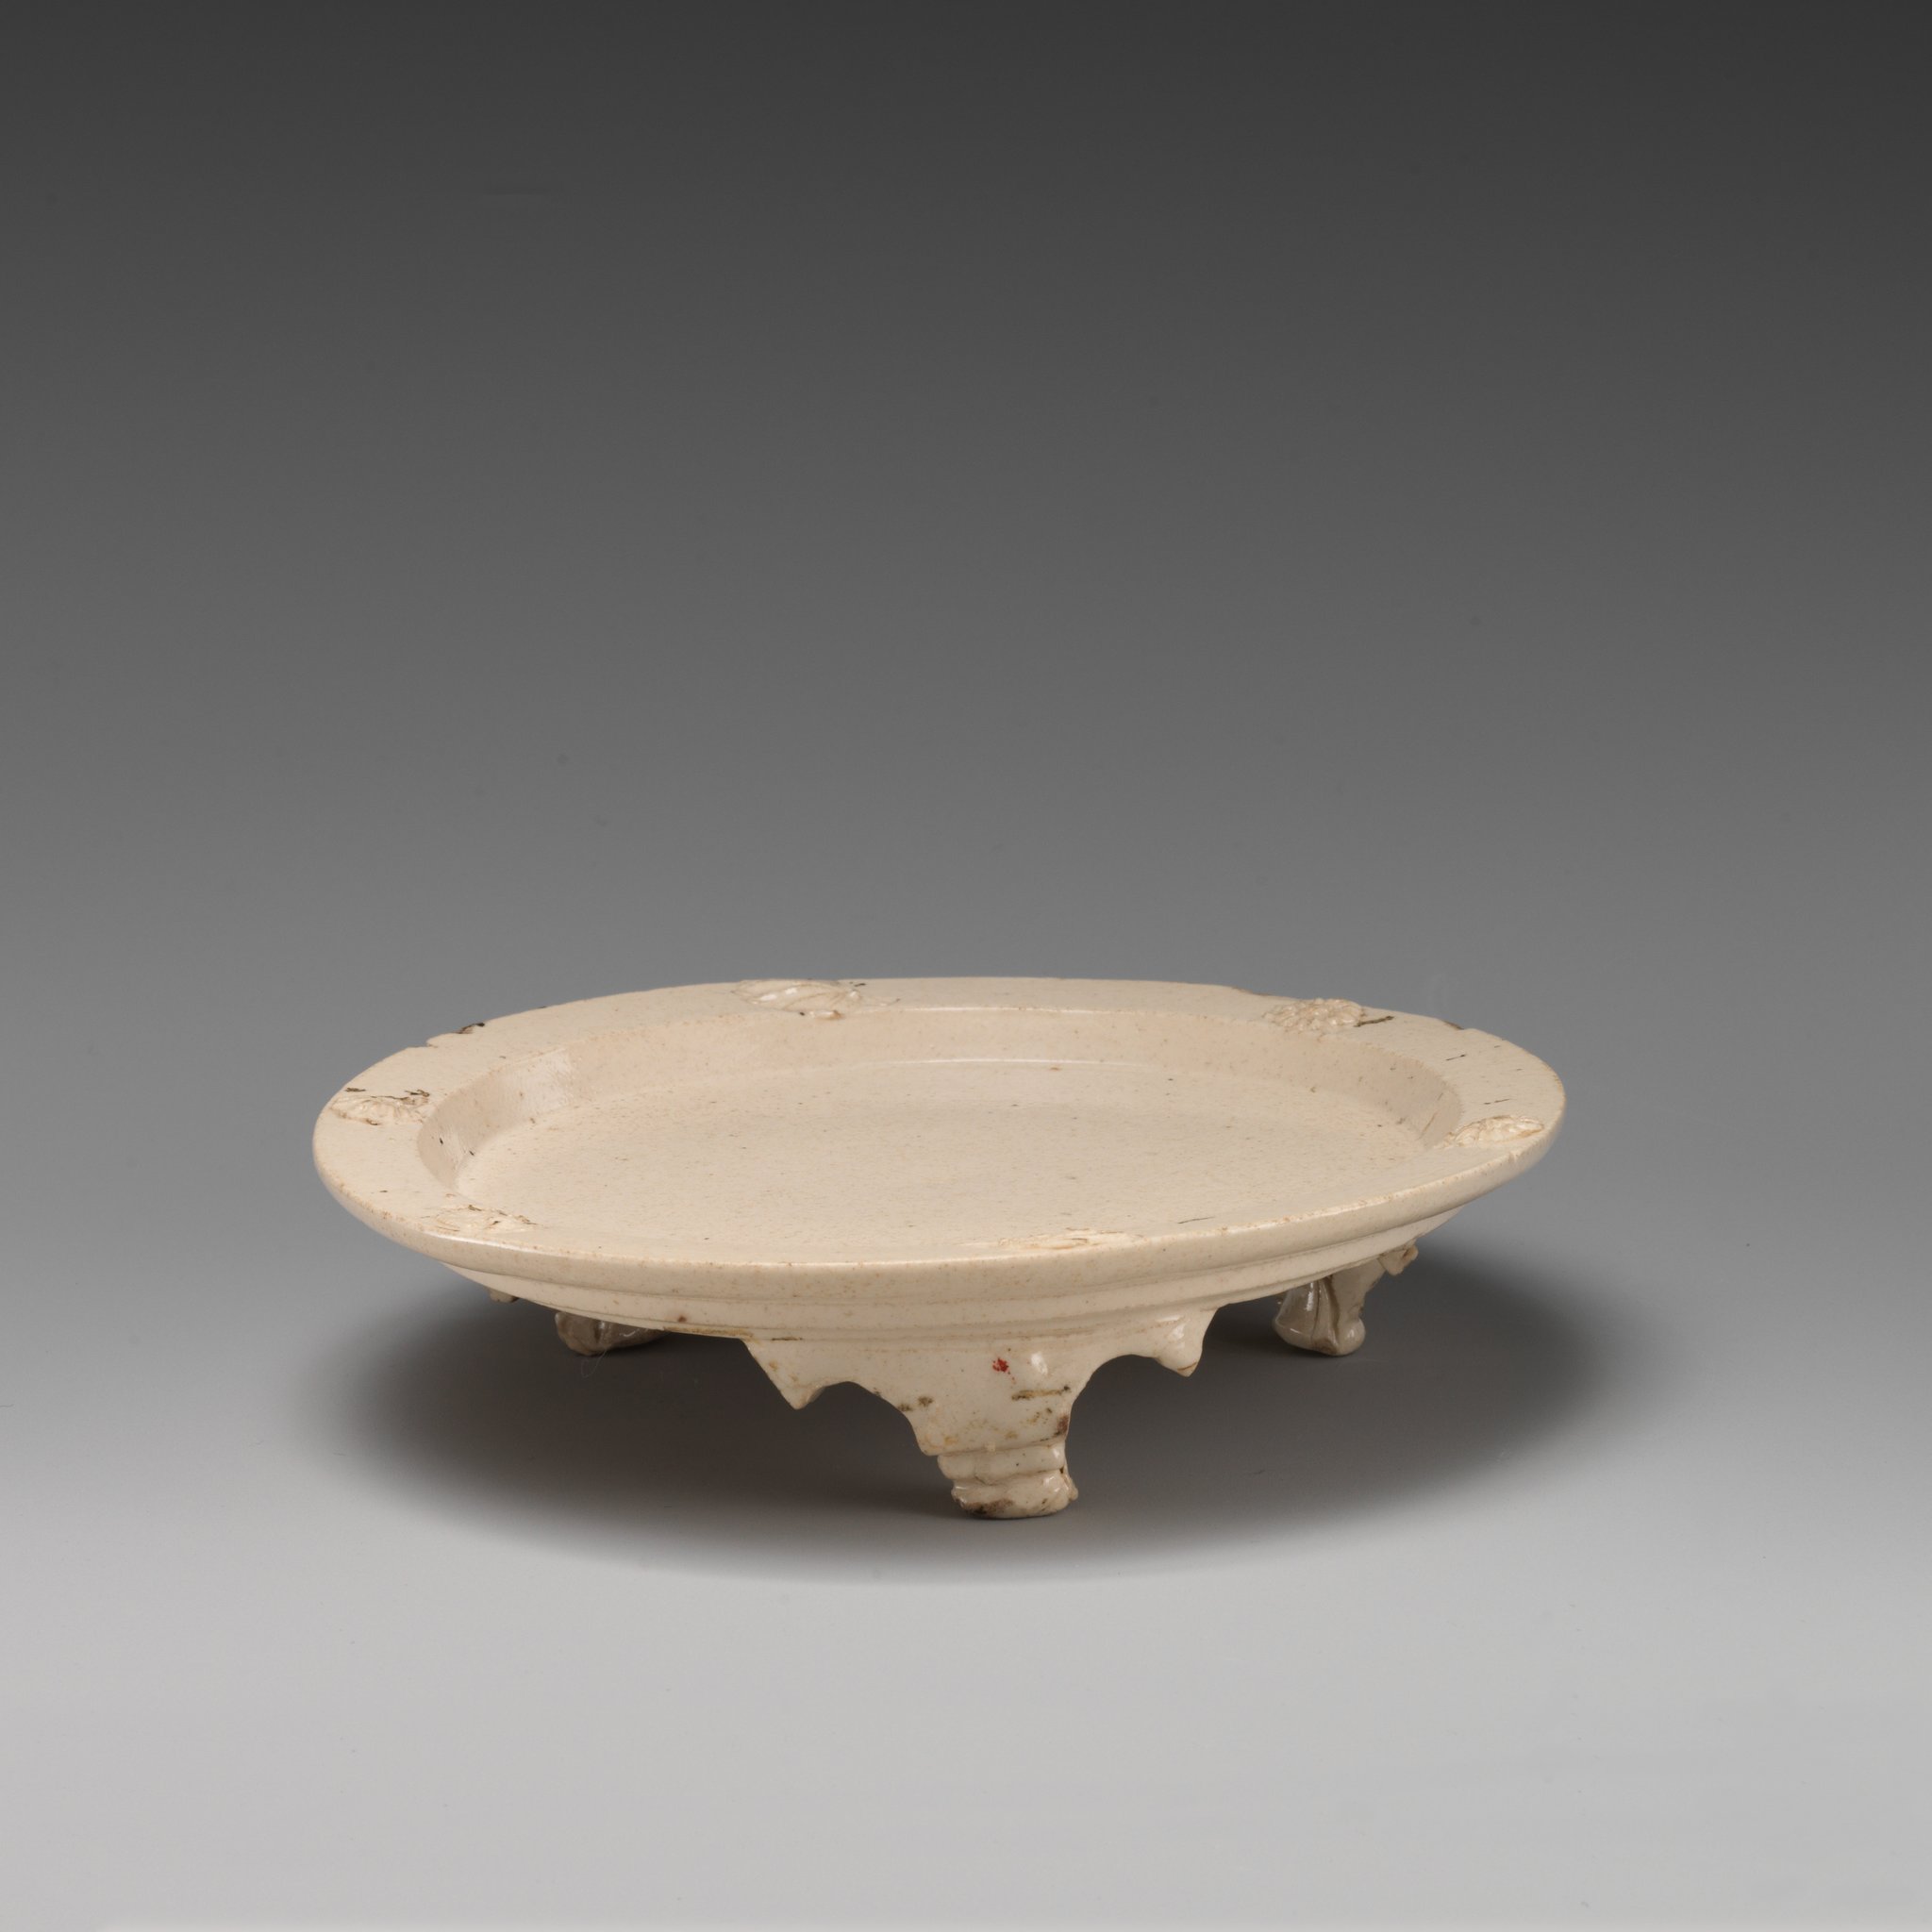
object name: teapot stand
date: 1740-1750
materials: stoneware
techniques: salt glaze